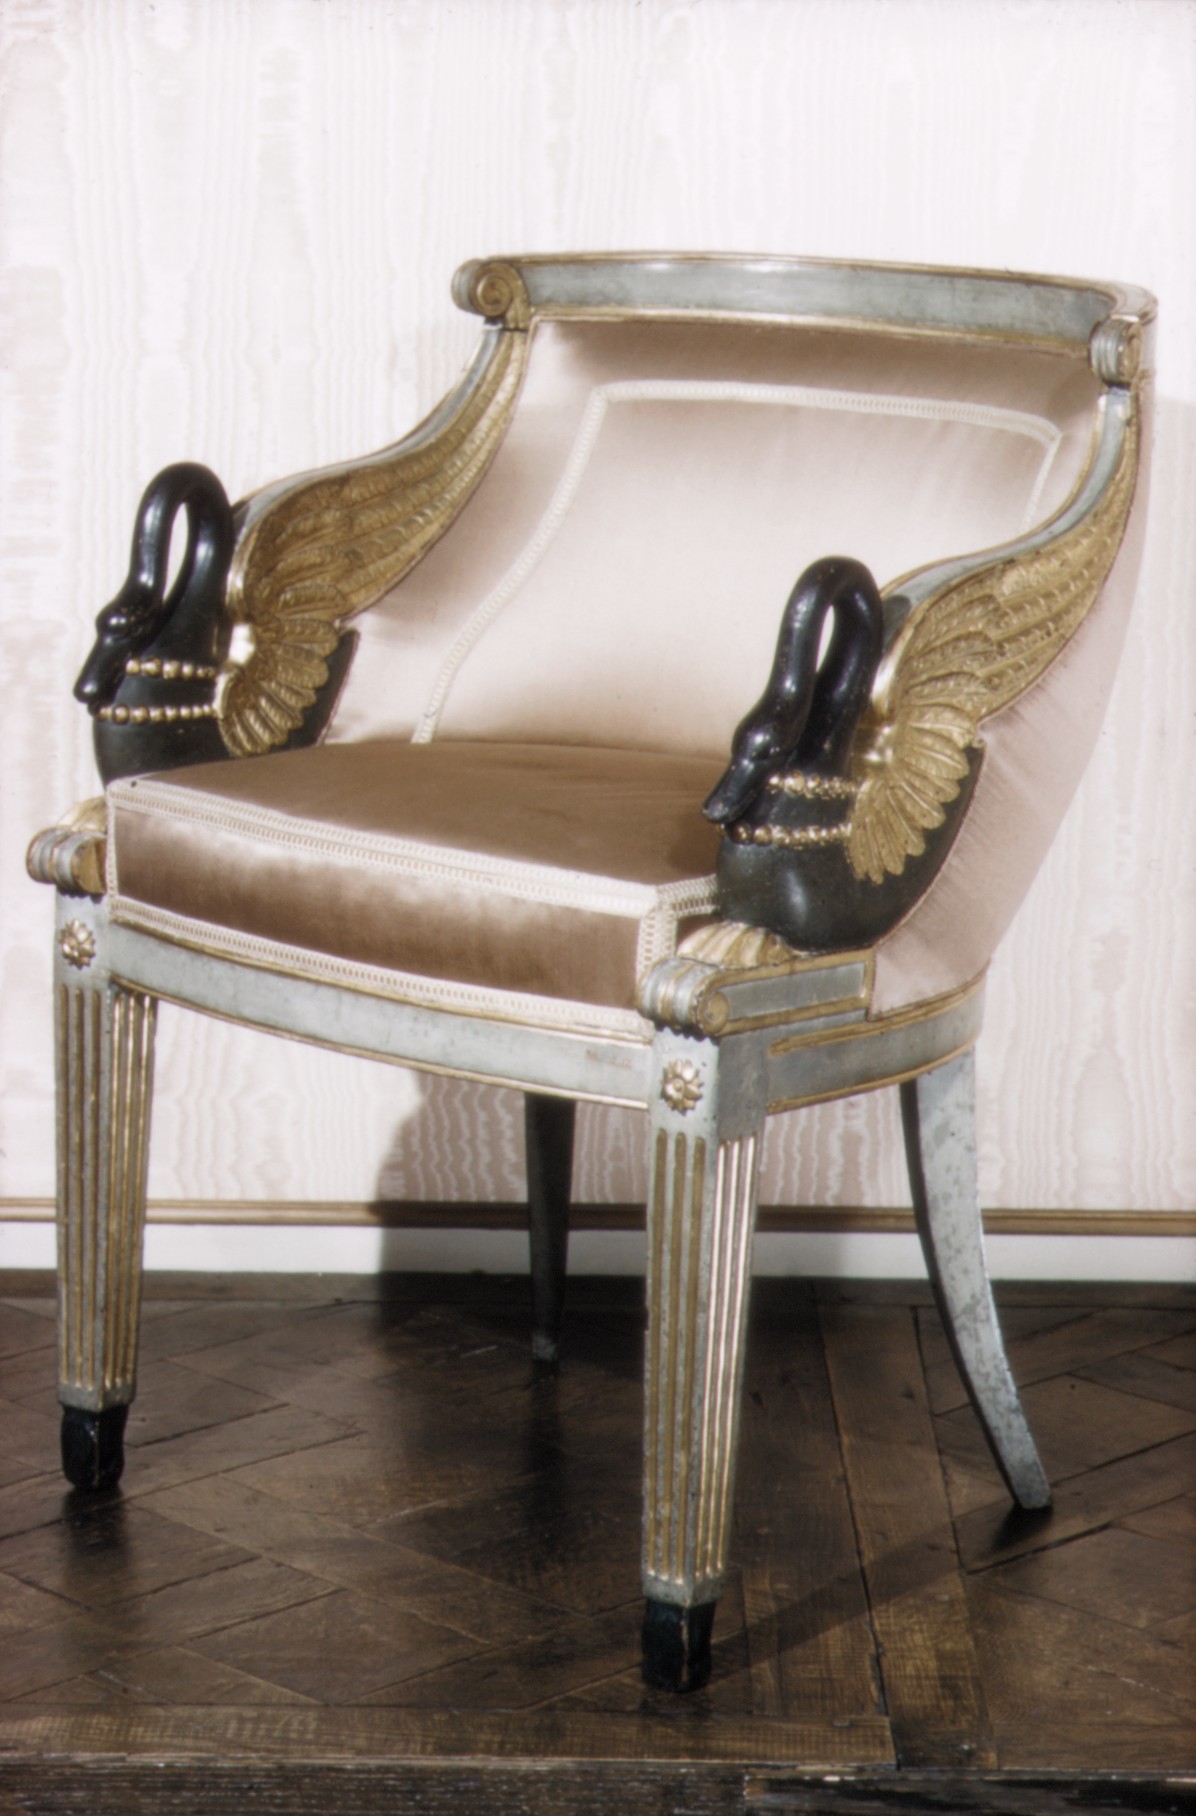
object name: armchair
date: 1805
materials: wood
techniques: carving, gilding, painting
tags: swans